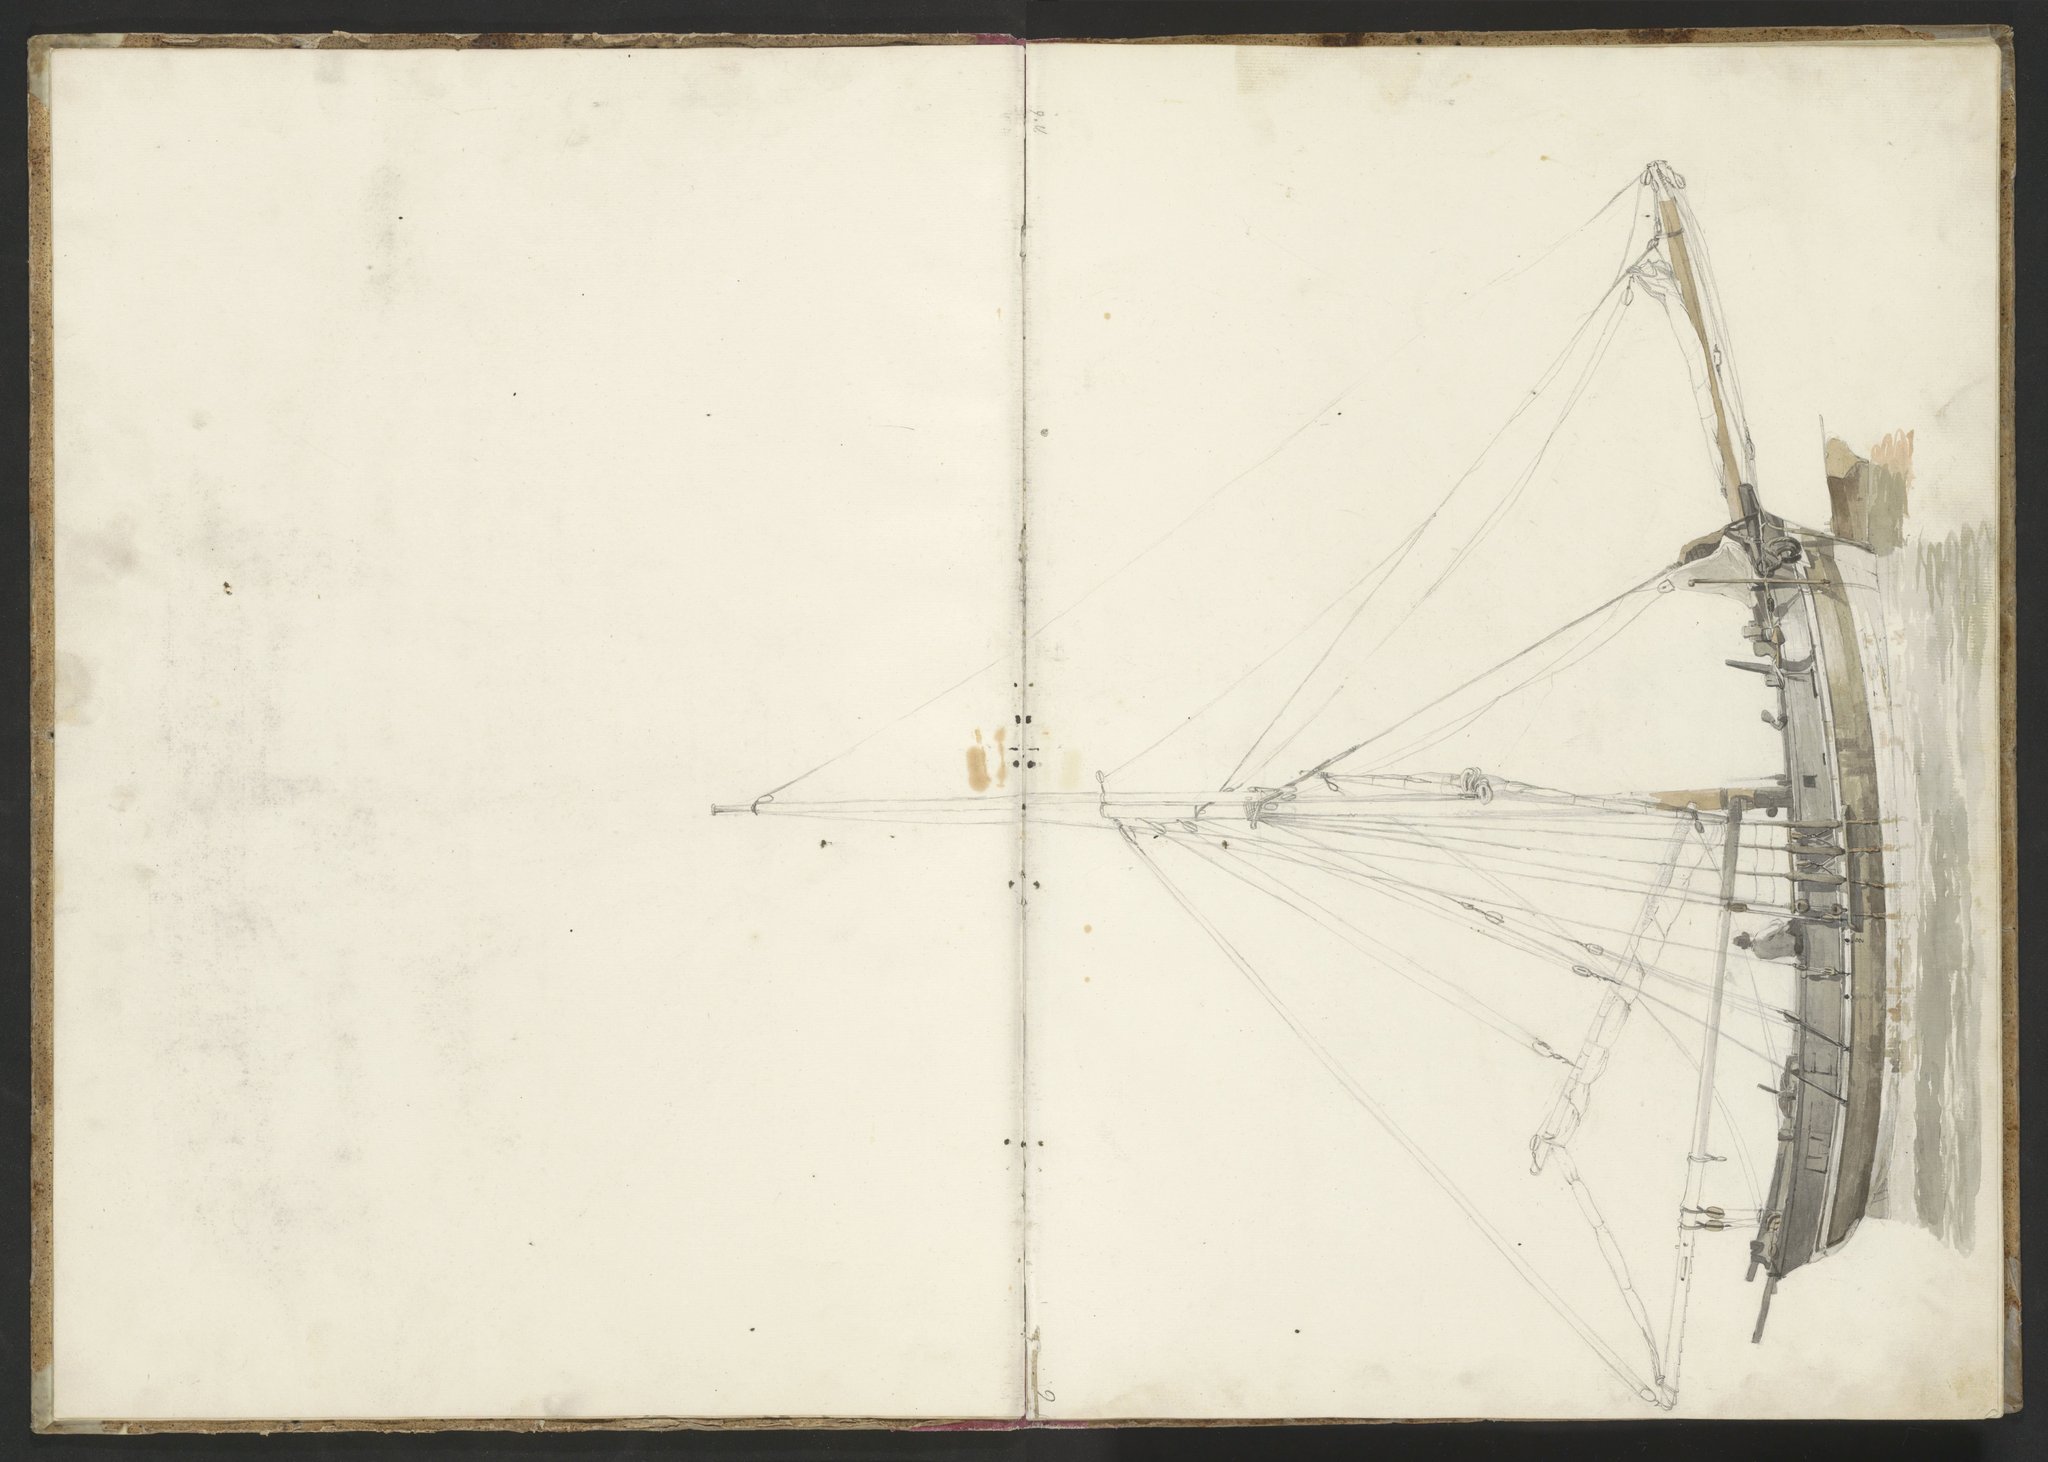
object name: sketchbook leaf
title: Man op een zeilschip op kalm water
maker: johannes christiaan schotel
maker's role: draughtsman, painter, print maker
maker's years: 1787-1838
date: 1797-1838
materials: paper, pencil, watercolor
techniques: brush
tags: sailing-ship, sailing-boat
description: Blad 5 verso en 6 recto uit een schetsboek met 65 bladen.